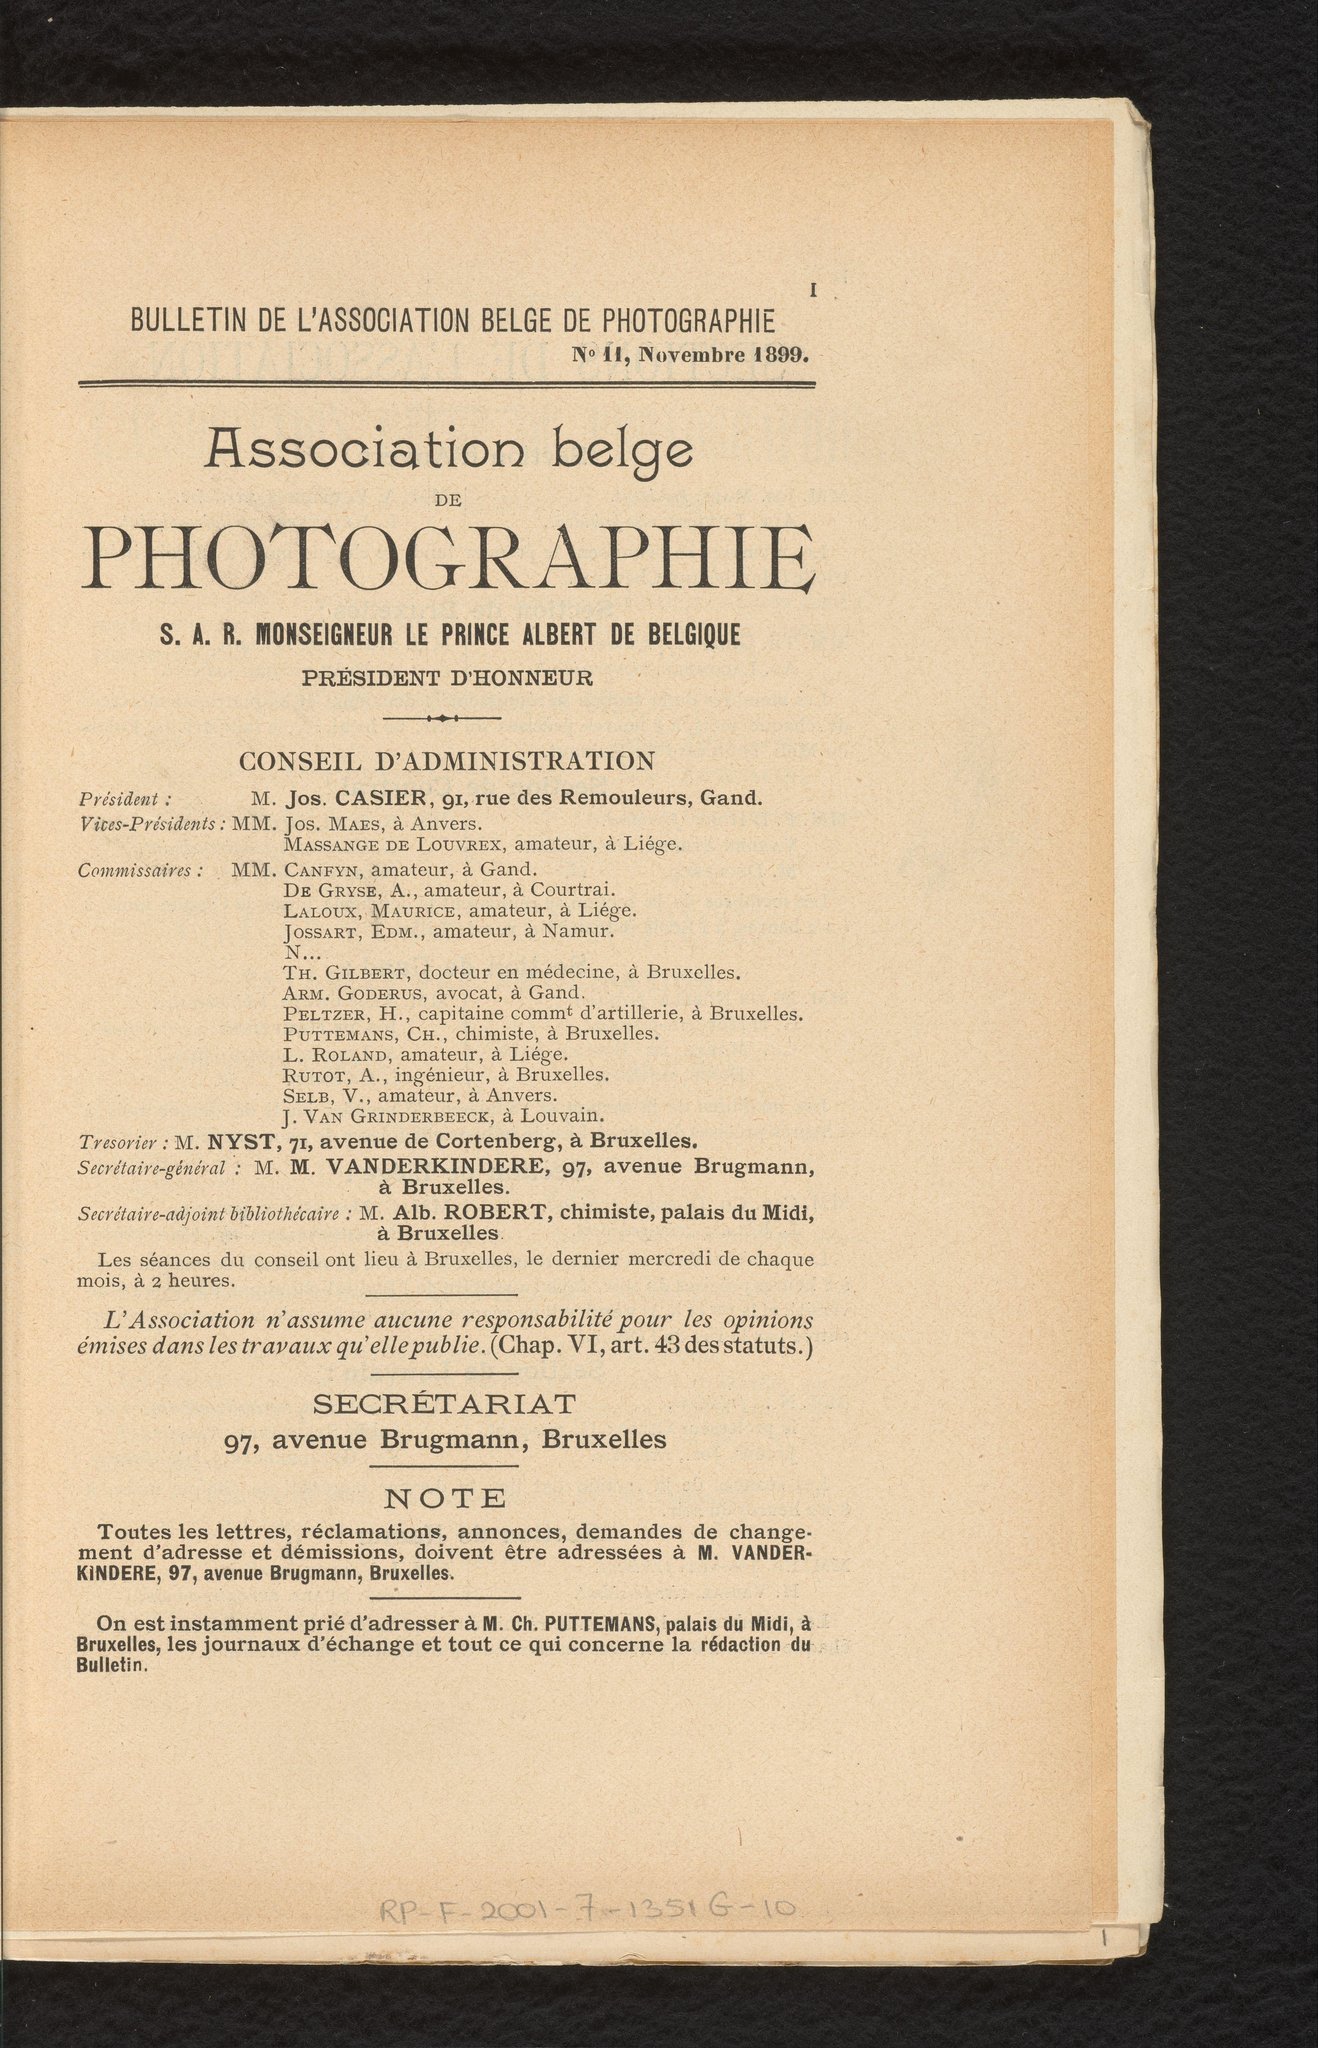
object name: book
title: Bulletin / Association belge de photographie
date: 1811-1899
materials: paper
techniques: photograph, printing, engraving